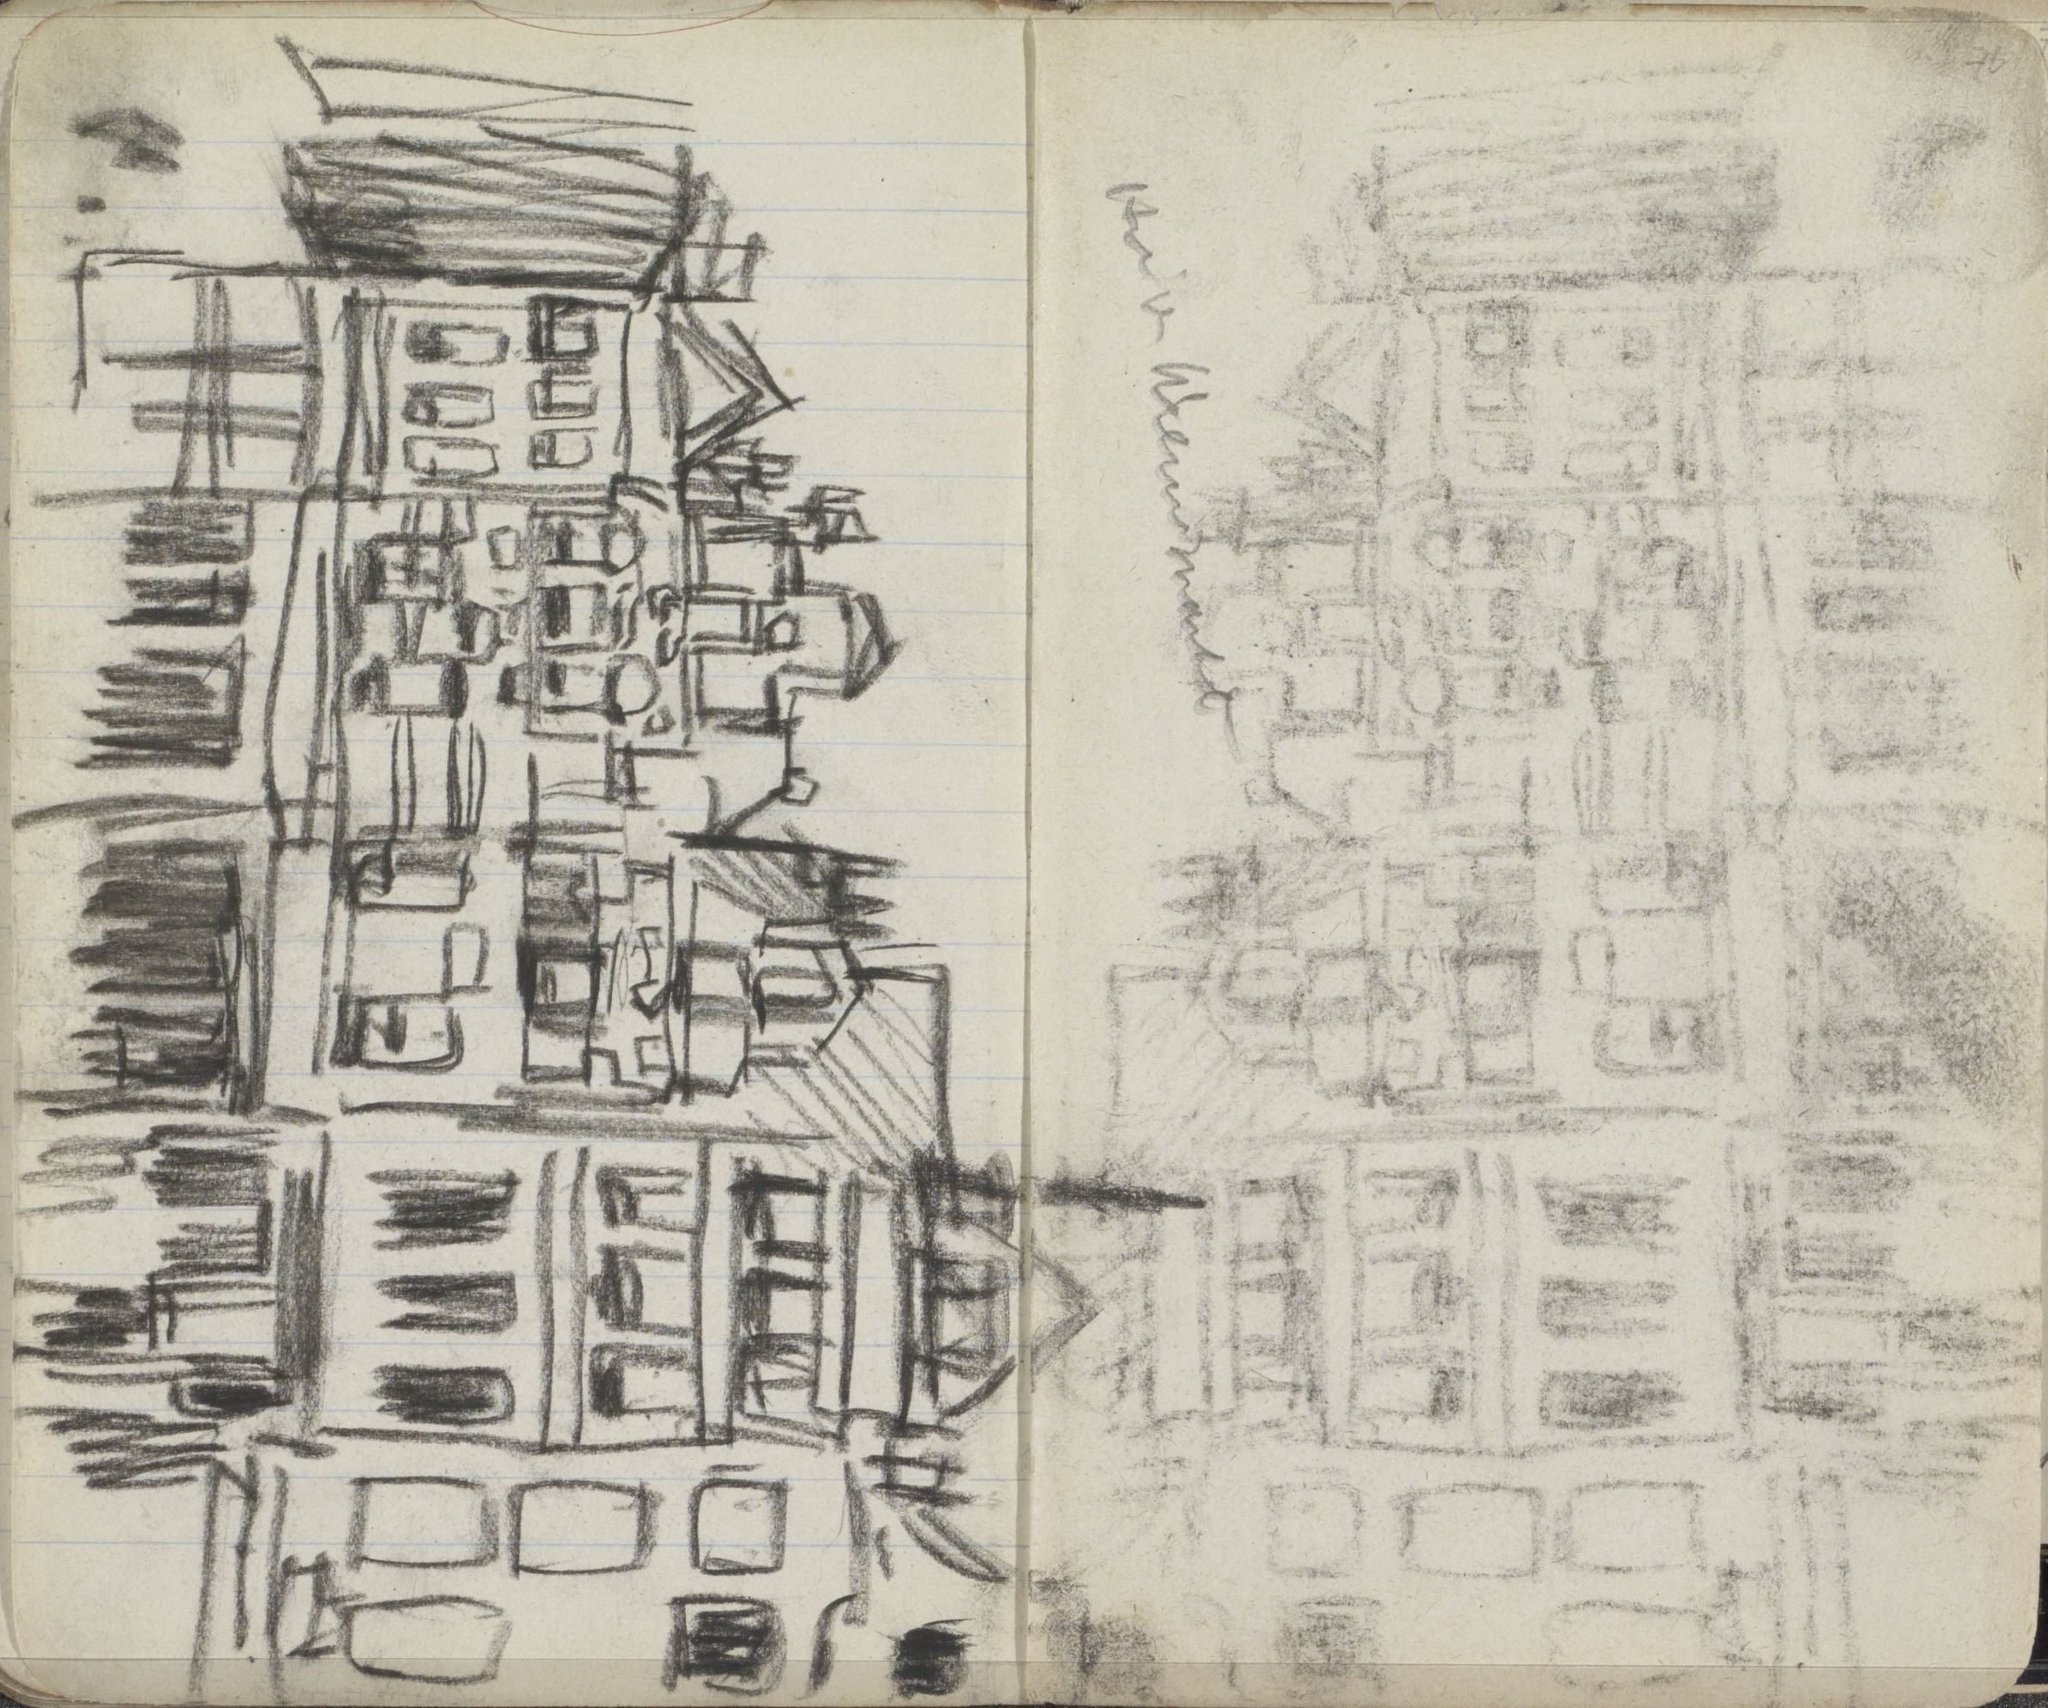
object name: sketchbook leaf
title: Huizen aan de Nieuwmarkt te Amsterdam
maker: george hendrik breitner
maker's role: draughtsman, painter, print maker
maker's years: 1857-1923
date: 1893-1898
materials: chalk, paper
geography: amsterdam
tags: urban housing, city-view, and landscape with man-made constructions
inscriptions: annotation: ‘Huisjes Nieuwmarkt’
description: Pagina 75 en pagina 76 uit een schetsboek met 38 bladen.